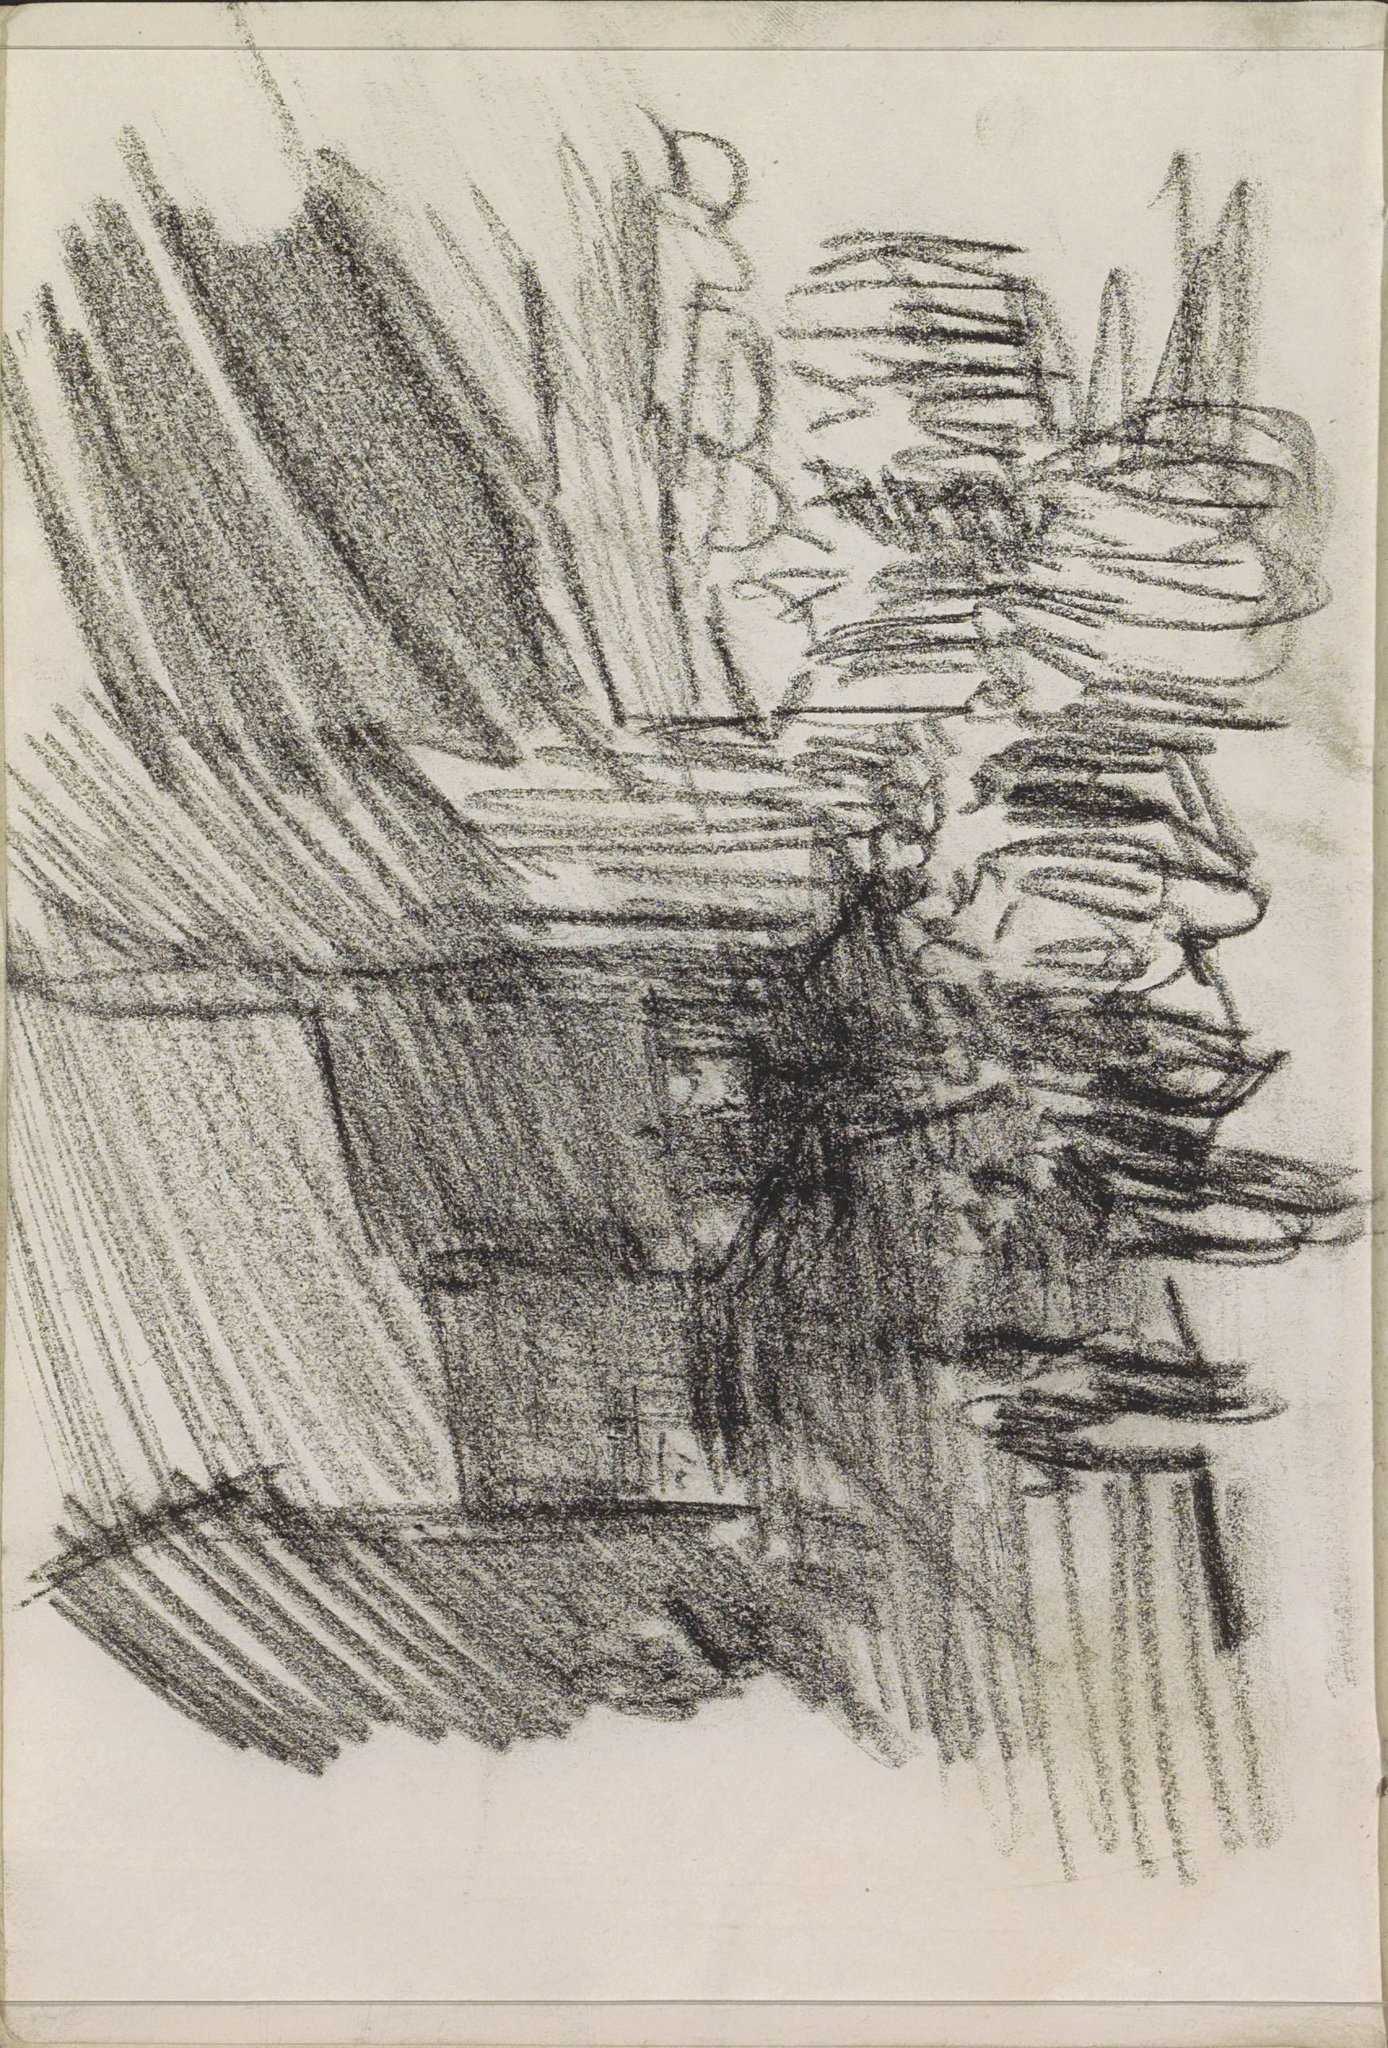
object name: sketchbook leaf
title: Figuren op straat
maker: isaac israels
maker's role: draughtsman, painter, print maker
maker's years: 1865-1934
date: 1875-1934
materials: chalk, paper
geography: paris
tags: street (+ city(-scape) with figures, staffage), paris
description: Mogelijk in Parijs. Blad 1 verso uit schetsboek L met 42 bladen.